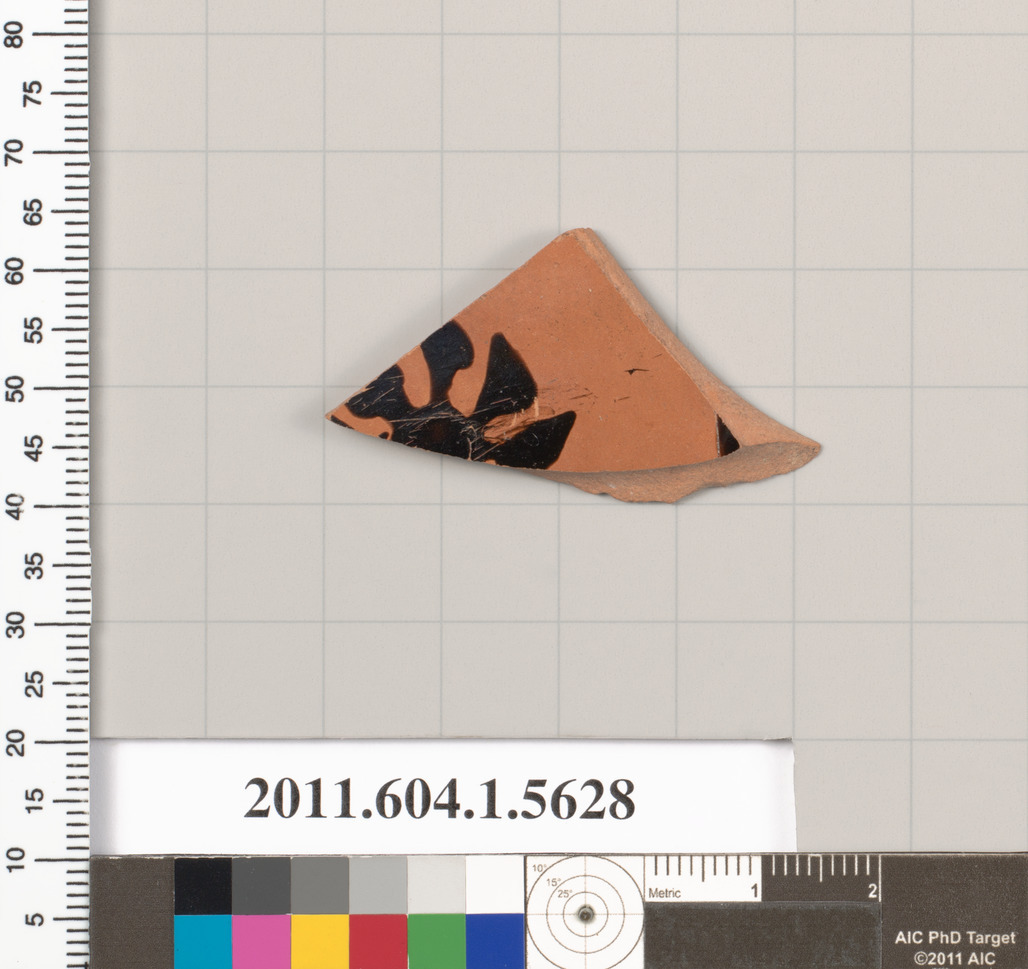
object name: kylix fragment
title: Terracotta fragment of a kylix (drinking cup)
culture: greek, attic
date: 520-500 BCE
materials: terracotta